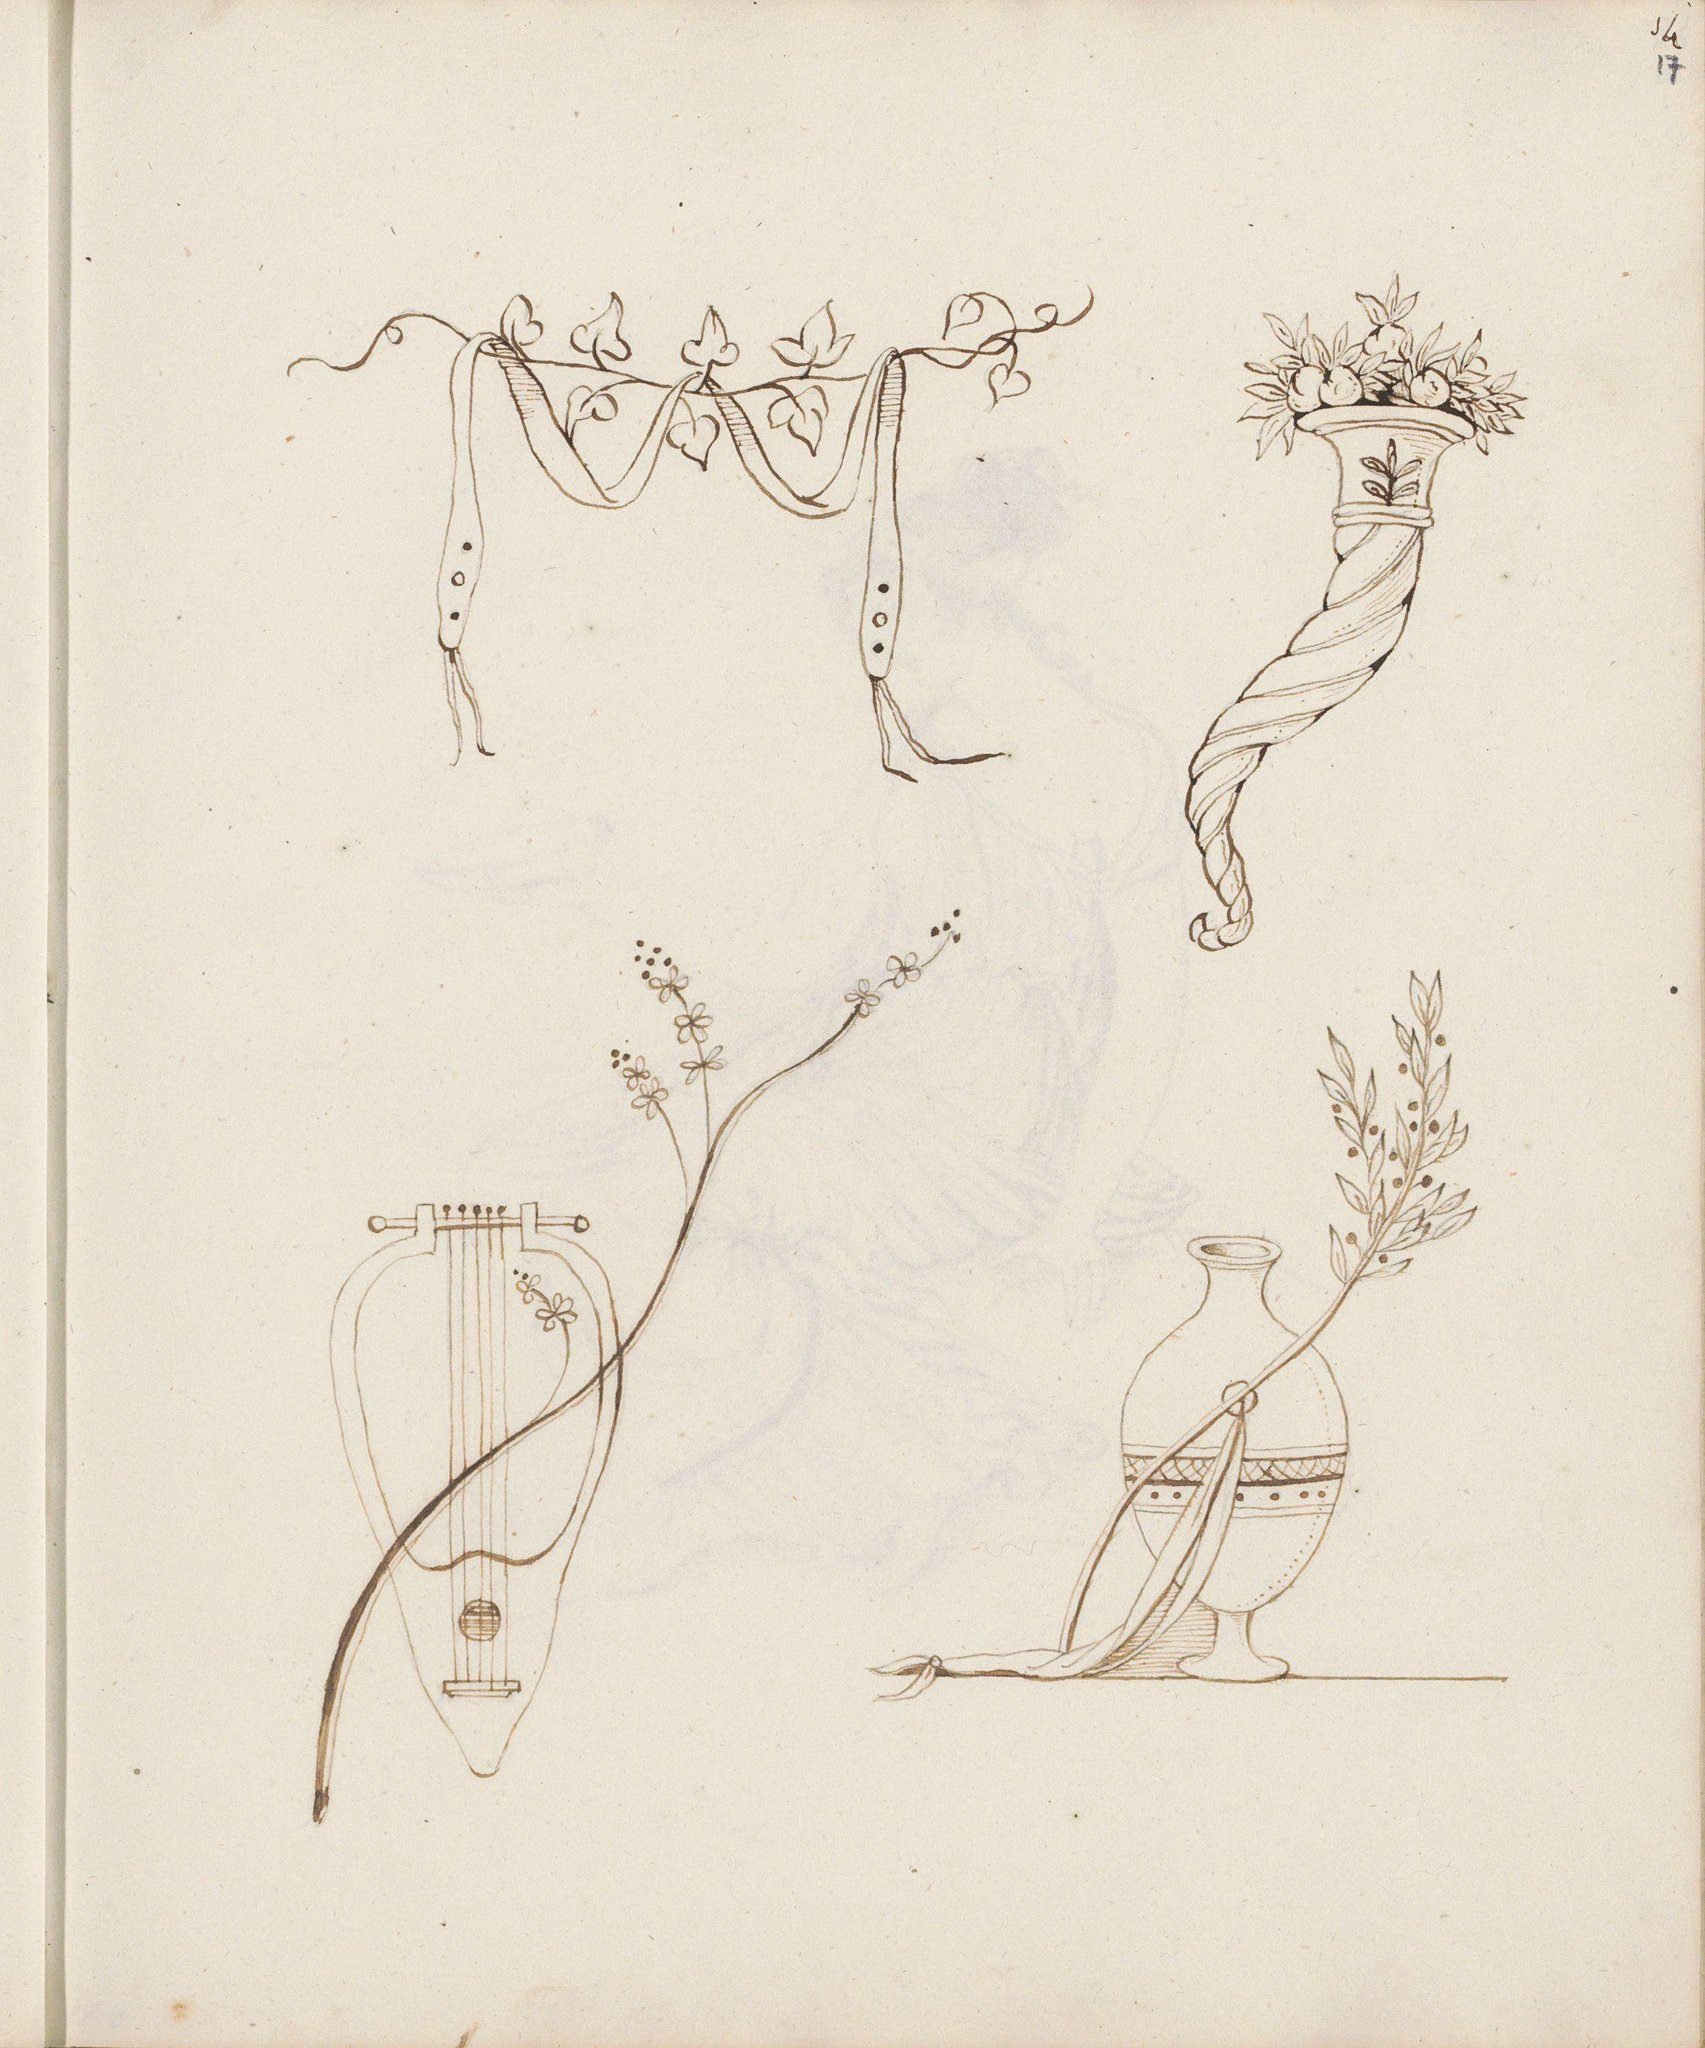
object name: sketchbook leaf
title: Guirlande, een cornucopia, een lier en een Griekse vaas met een olijftak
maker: jonkvrouw elisabeth kemper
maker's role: draughtsman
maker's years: 1799-1871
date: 1815-1852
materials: ink, paper, pencil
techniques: pen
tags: 'cornucopia', horn of plenty, lyre, cithara, psaltery, garland, wreath, container of stone: stone vase, trees: olive-tree (+ branch, stick)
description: Blad 17 recto uit een schetsboek met 94 bladen.